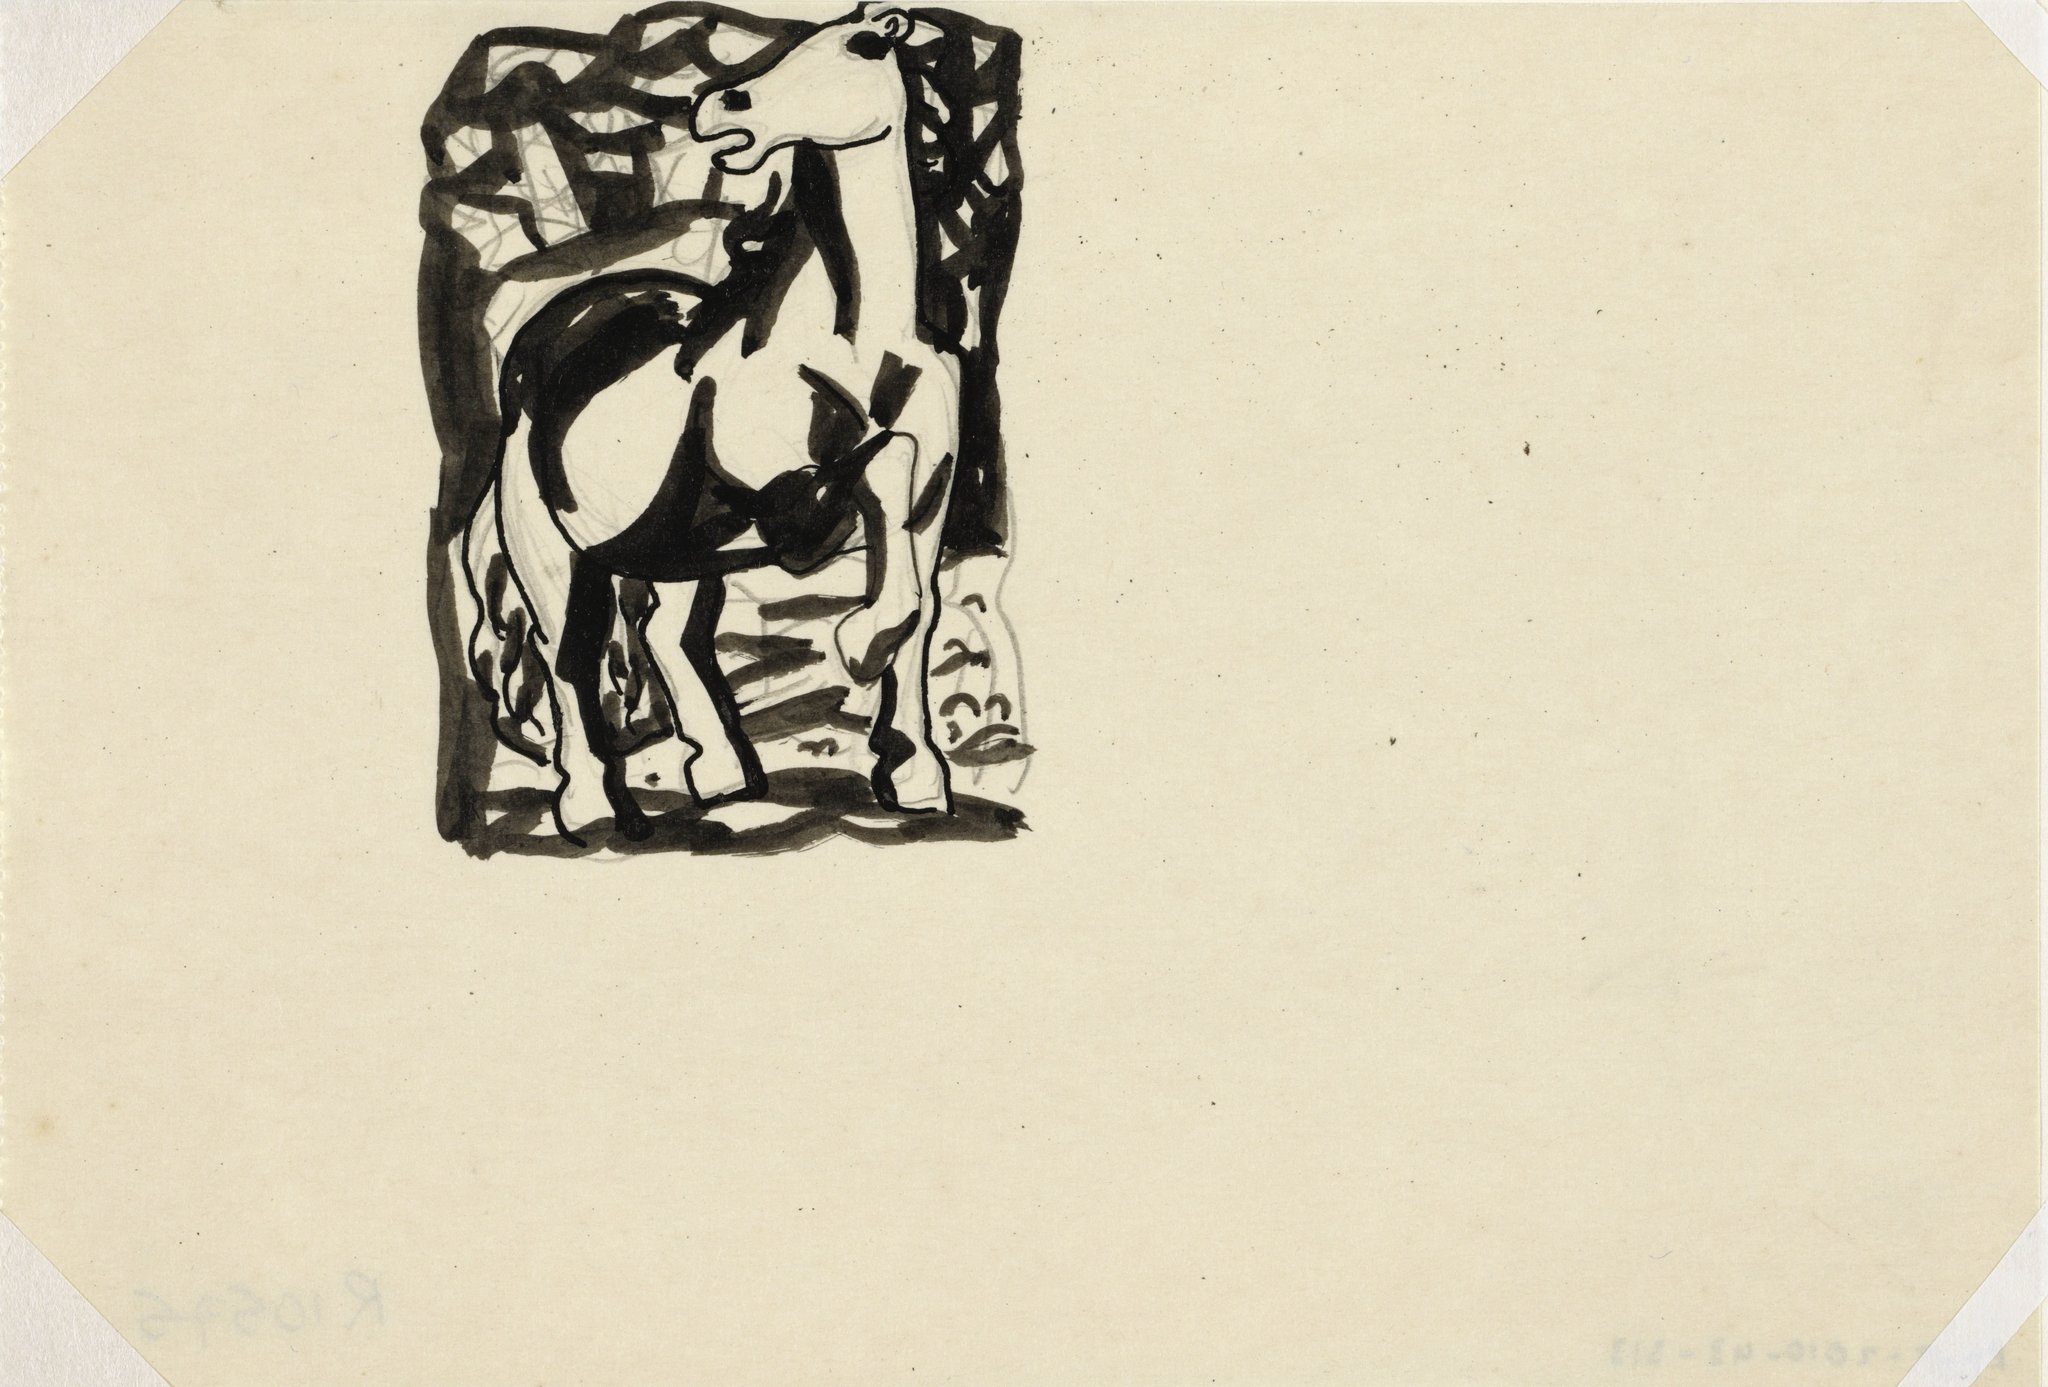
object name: drawing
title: Zonder titel (paard)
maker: leo gestel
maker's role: draughtsman, print maker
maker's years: 1881-1941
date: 1925-1940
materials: ink, paper, pencil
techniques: brush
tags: horse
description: Paard met hoofd naar links en rechter voorbeen omhoog